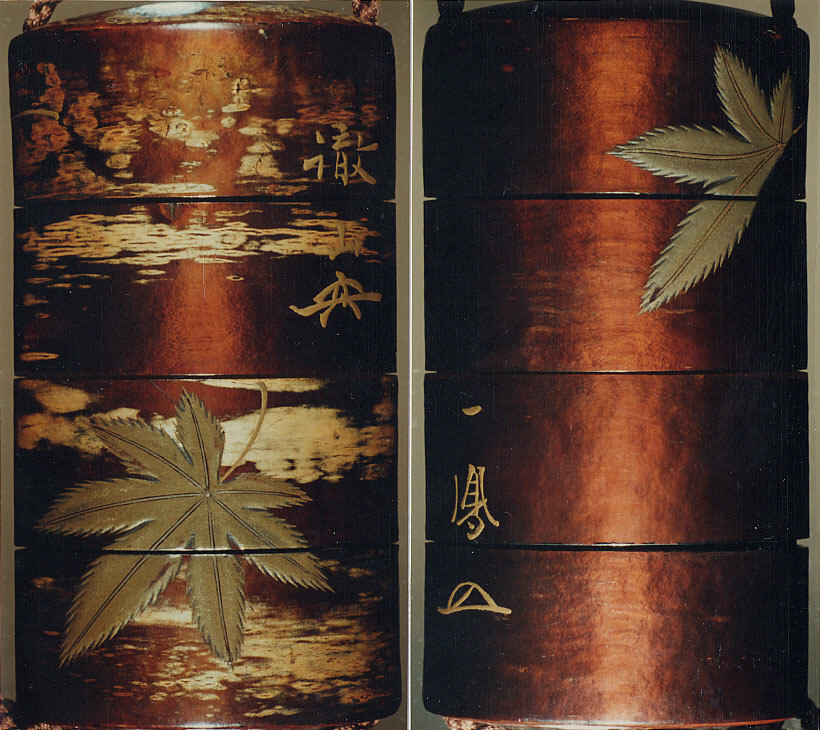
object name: inrō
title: Case (Inrō) with Design of Maple Leaves beside Inscriptions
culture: japanese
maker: kajikawa school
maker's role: artist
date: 1801-1900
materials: gold, lacquer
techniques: hiramakie, roiro